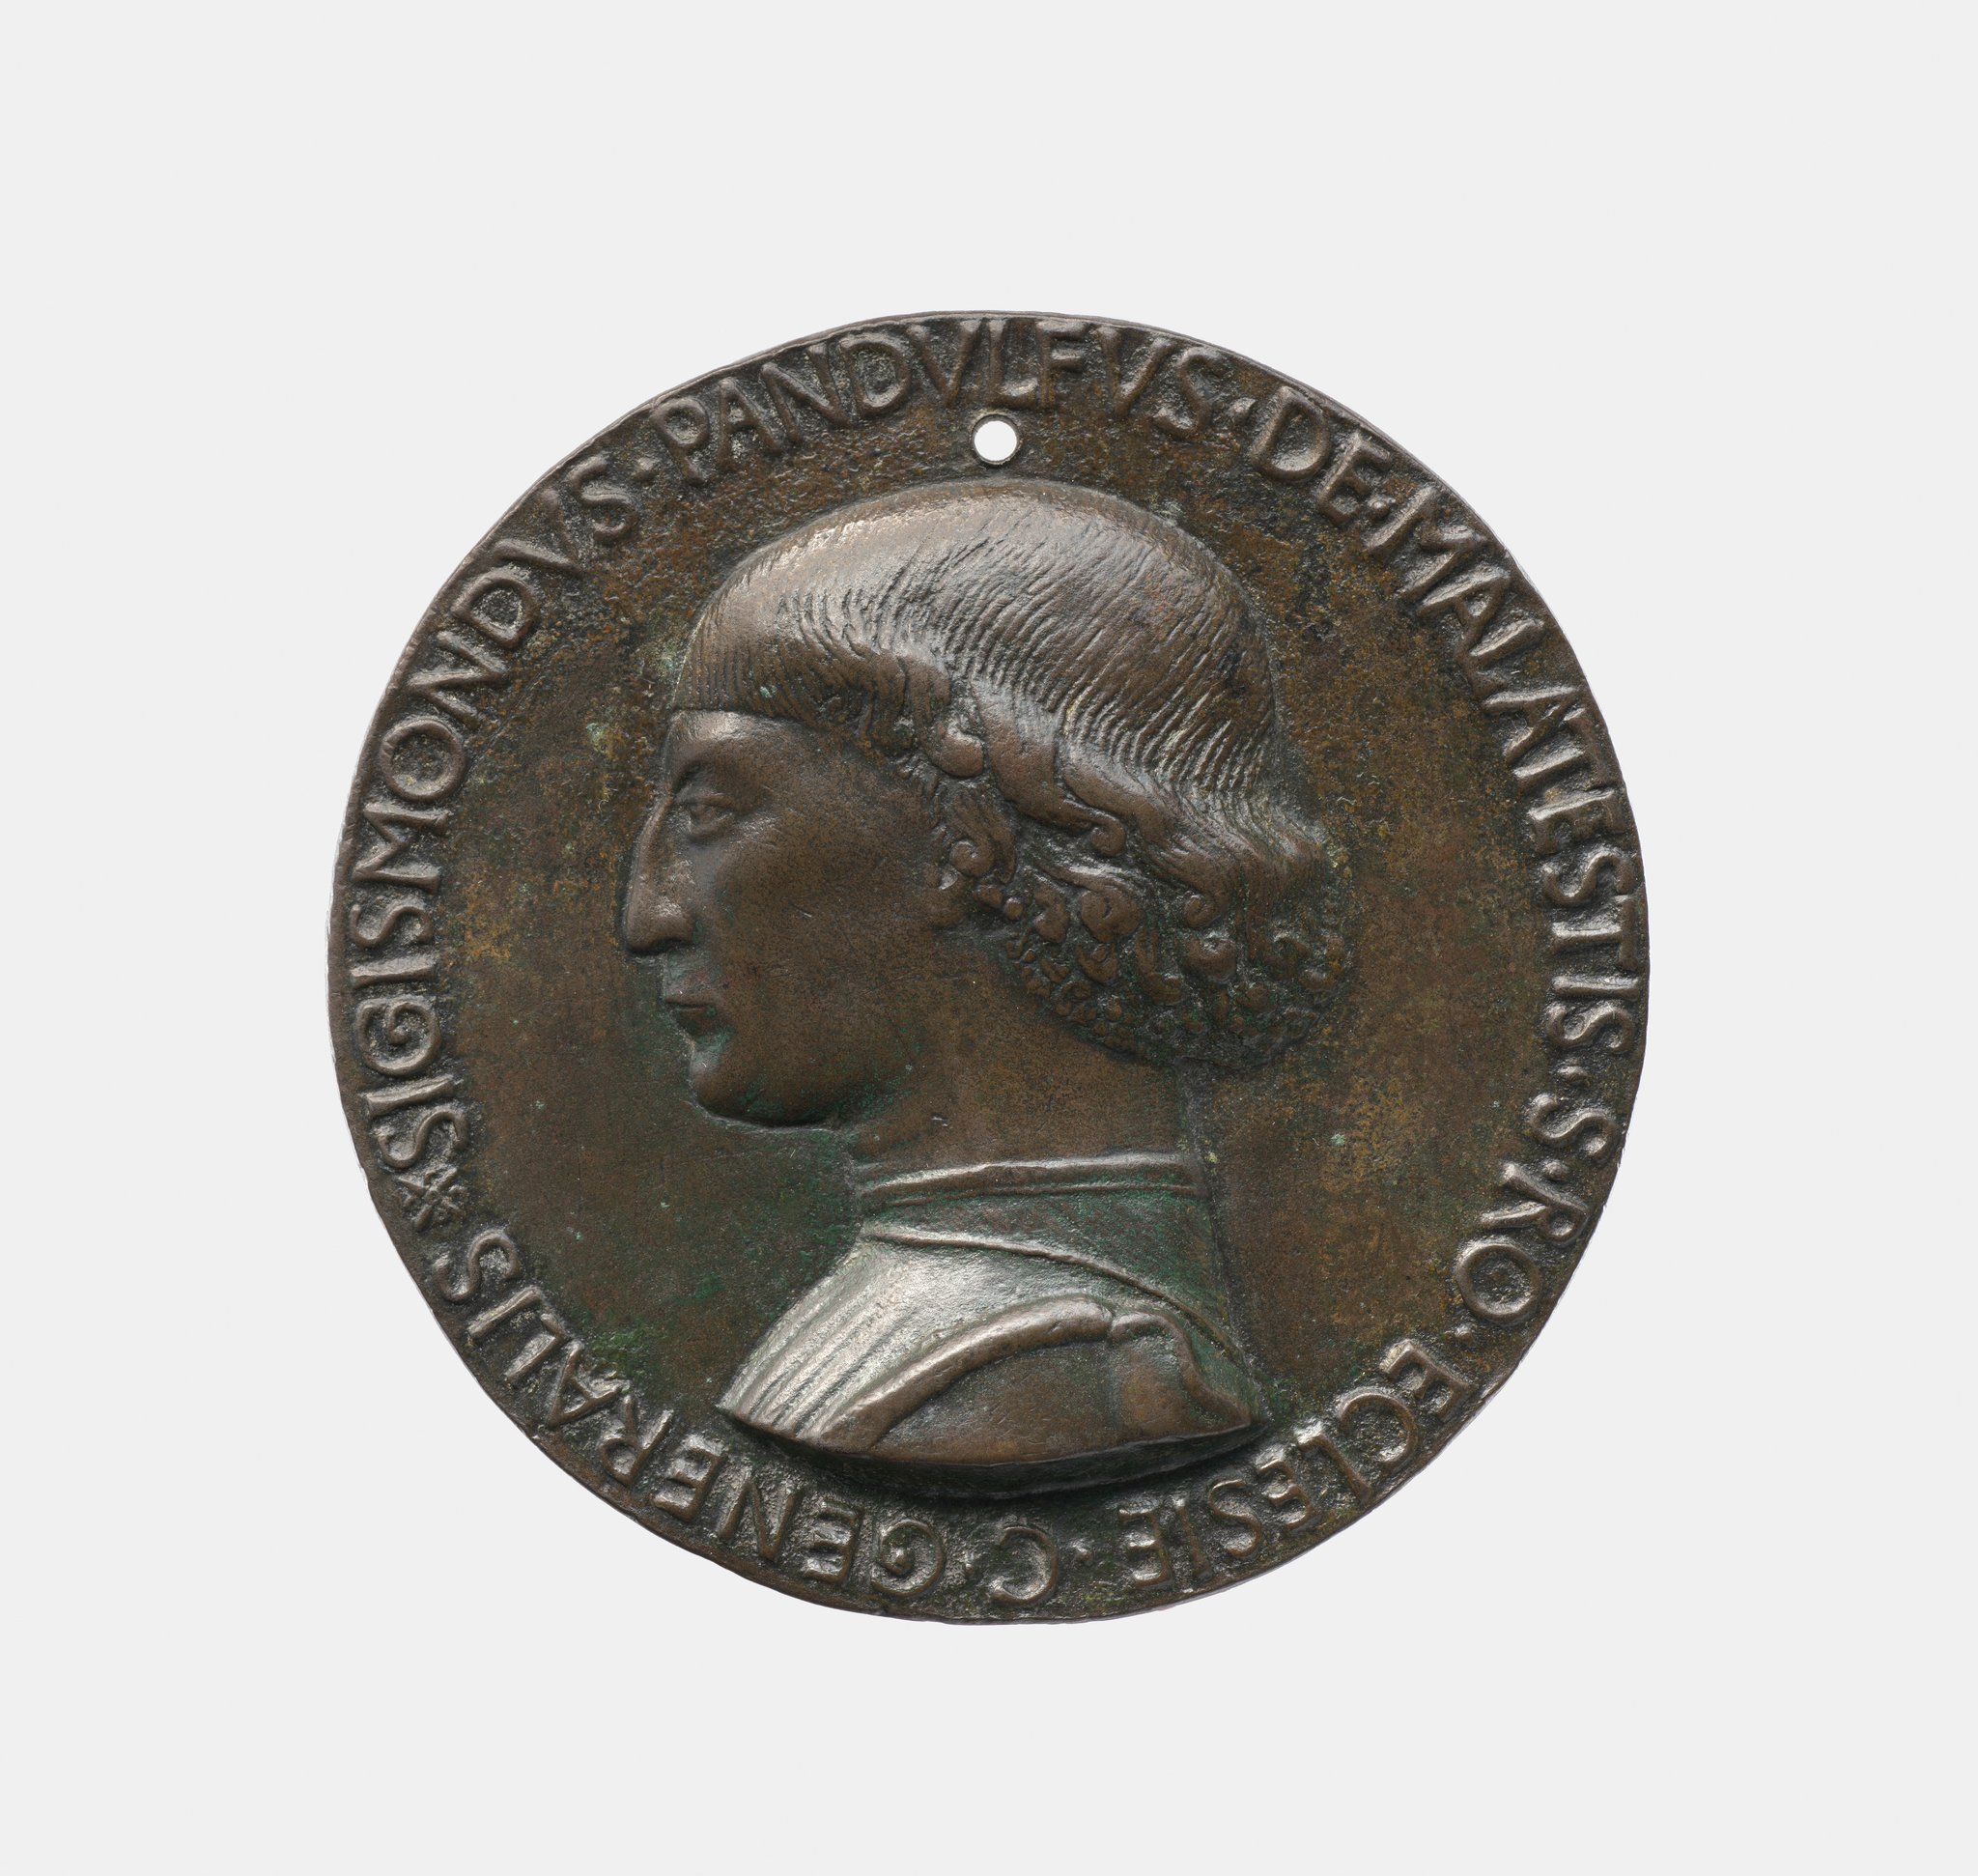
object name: medal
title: Sigismondo Pandolfo Malatesta 1417-68, Lord of Rimini 1432-68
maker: matteo de' pasti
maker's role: artist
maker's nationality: italian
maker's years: 1420-1467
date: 1446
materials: bronze